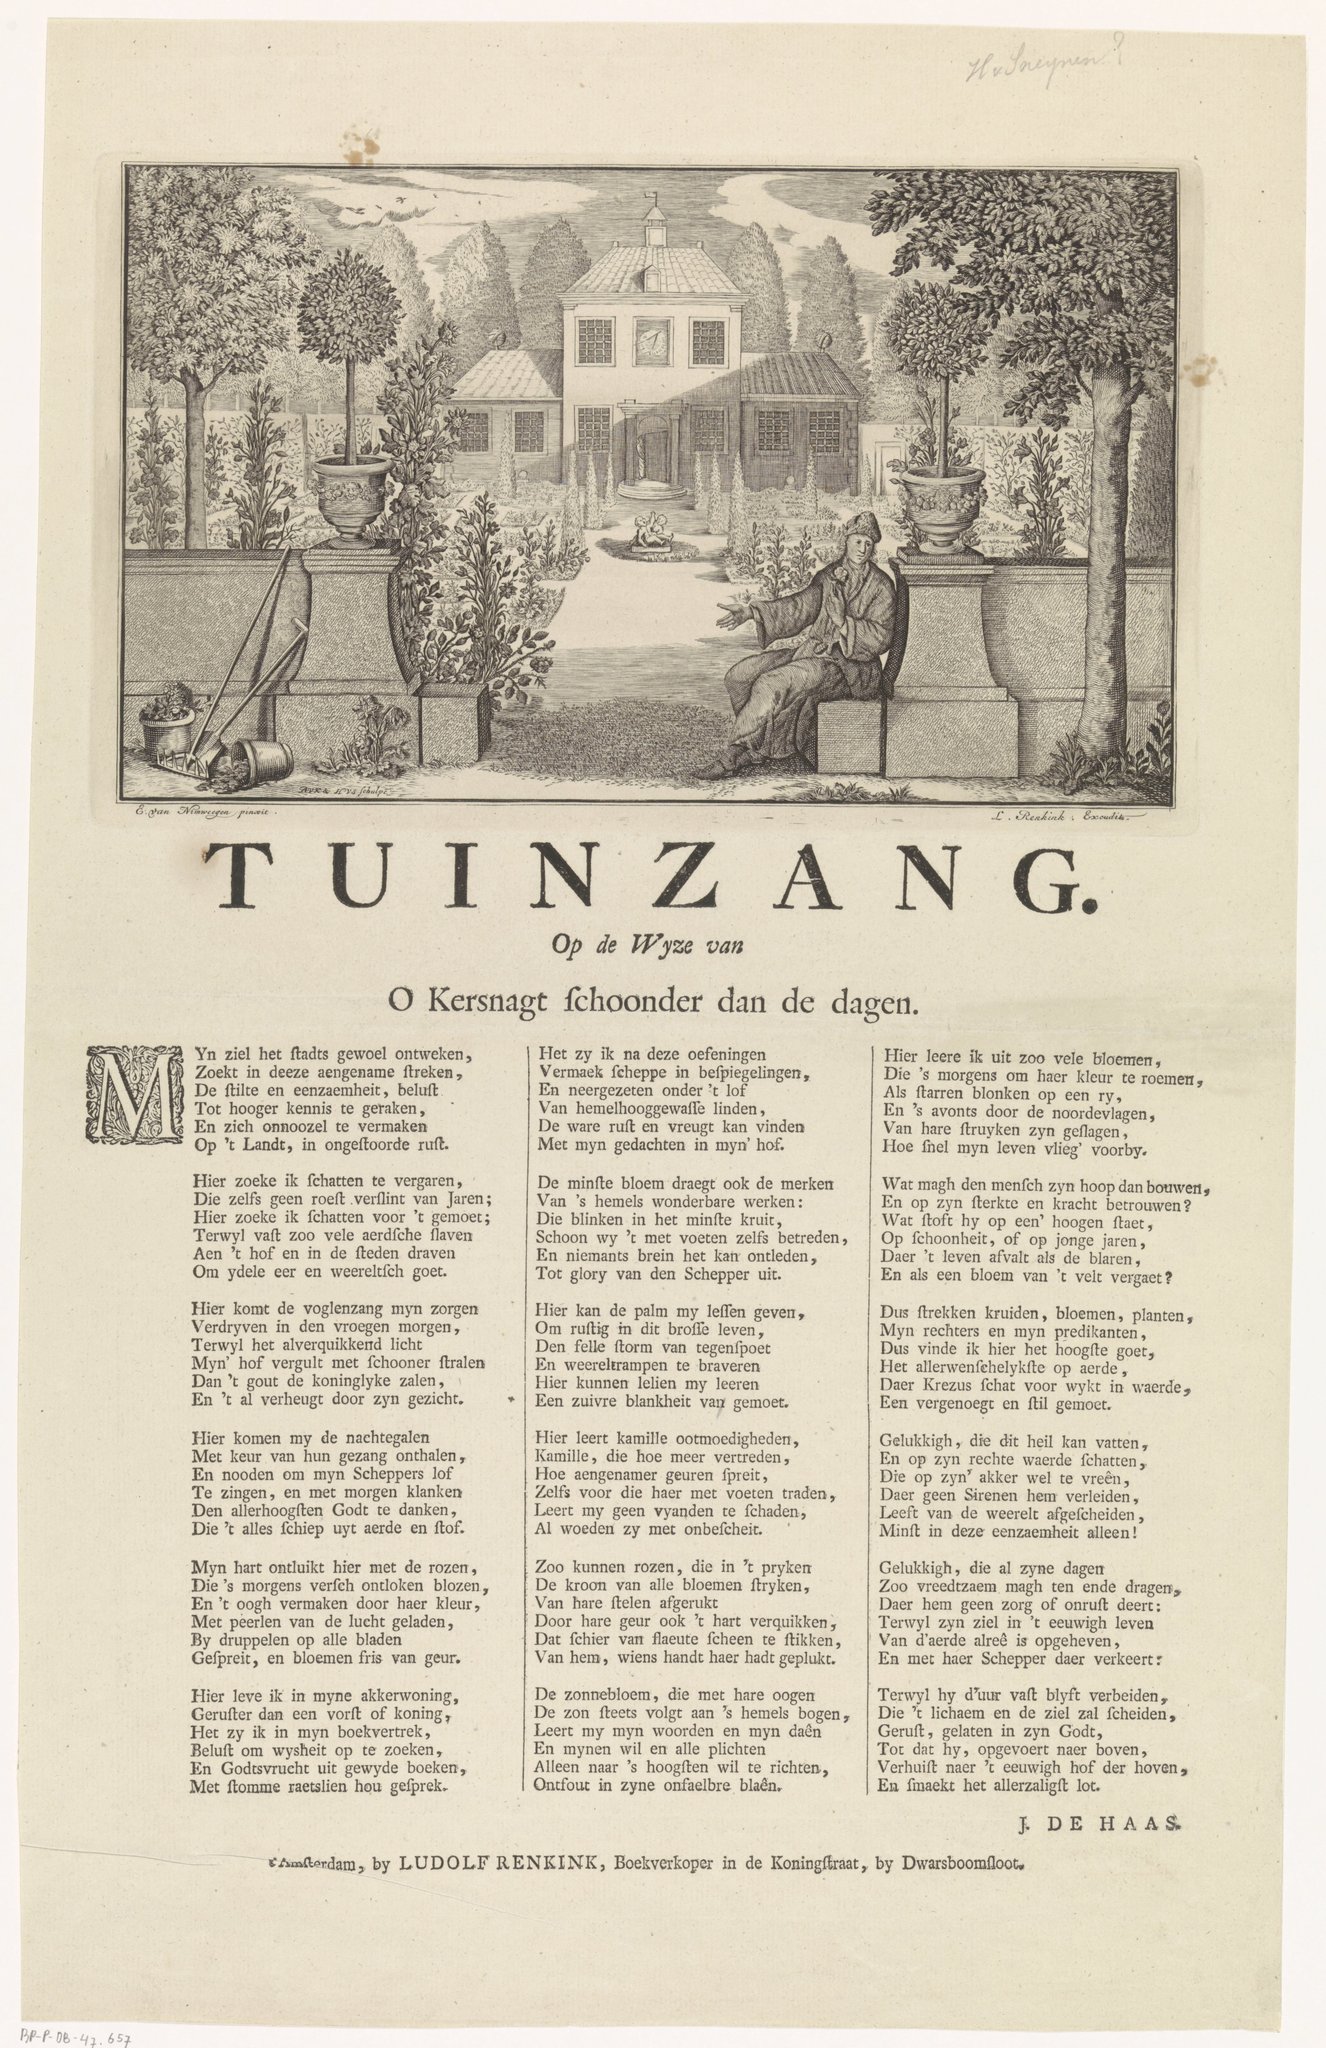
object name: print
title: Tuinzang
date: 1600-1699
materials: paper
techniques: engraving, etching, letterpress printing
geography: amsterdam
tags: male singer, flowers, garden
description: Bij de ingang van een weelderige tuin, met bloemen en planten, zit een man met een bloem in zijn hand. Gedrukt op het blad onder de plaat staat een vers in drie kolommen. Uit het vers blijkt dat de man een loflied zingt op de tuin en de verschillende planten en bloemen in de tuin. Het lied dient te worden gezongen op de melodie van 'O Kersnagt schoonder dan de dagen'.